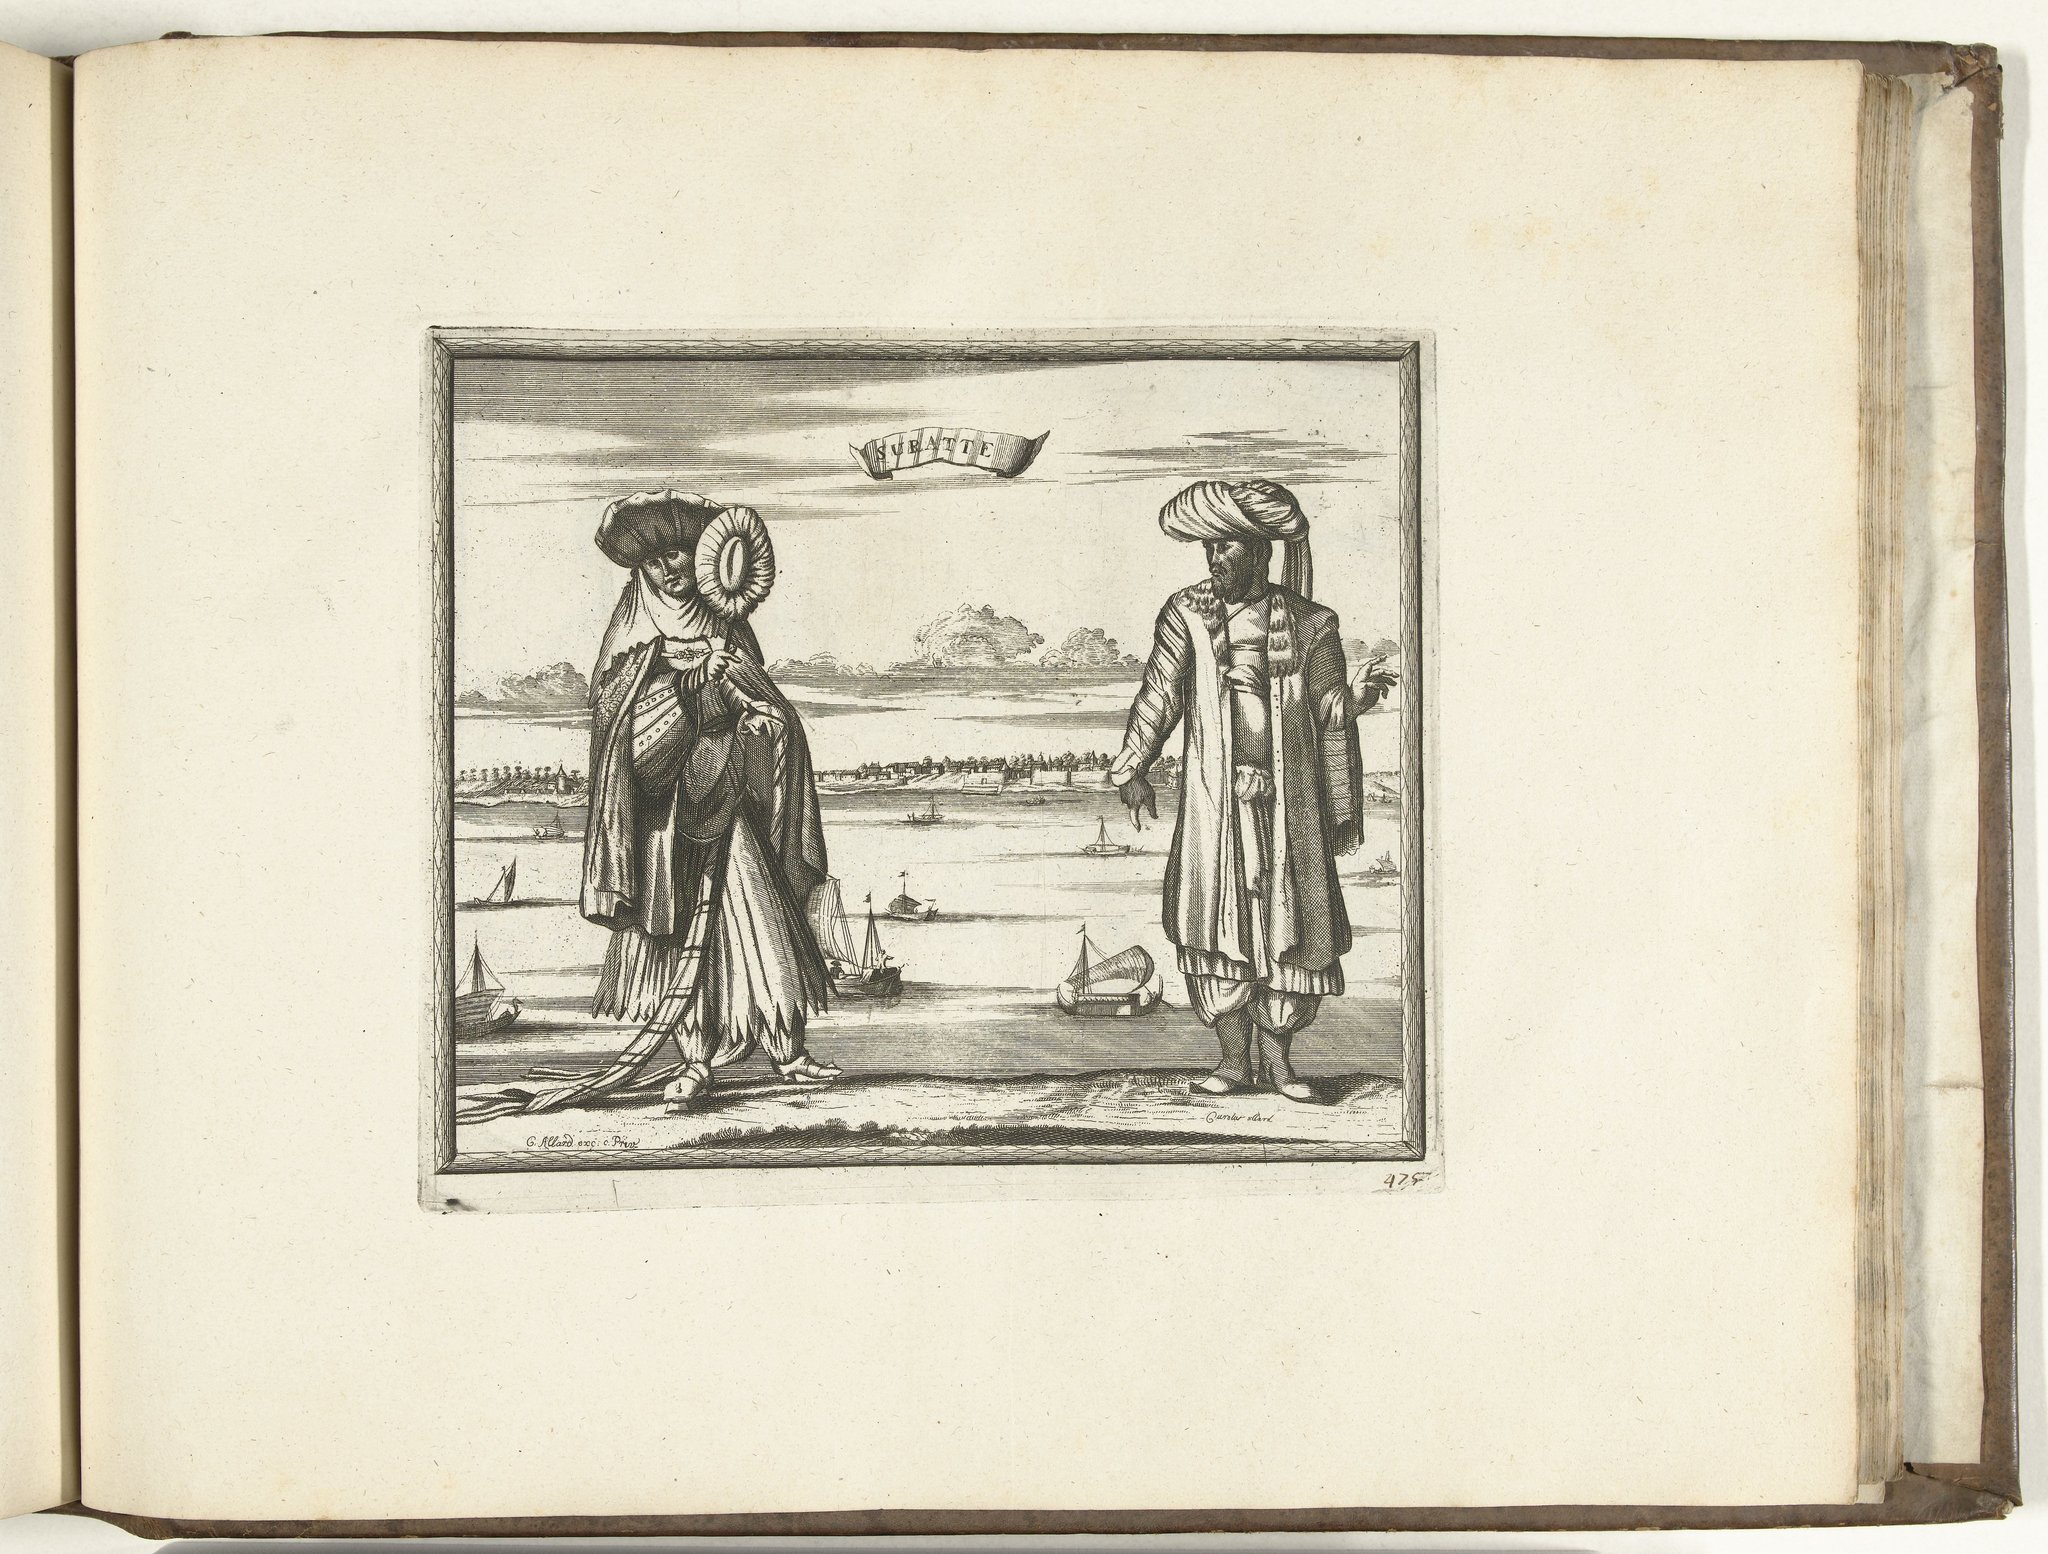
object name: print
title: Inwoners van Suratte, 1726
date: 1726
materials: paper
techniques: etching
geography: amsterdam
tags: folk costume, regional costume, asiatic races and peoples: indians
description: Man en vrouw van Suratte in India, gekleed in lokaal kostuum. Plaat nr. 475 in deel XIX van het prentwerk: Les Forces de l'Europe, Asie, Afrique et Amerique ... Comme aussi les Cartes des Côtes de France et d'Espagne uit 1726, dit tweede deel met 271 met de hand genummerde platen van vermaarde sterke steden en vestingen in het kader van de Spaanse Successieoorlog 1701-1713. Voor het merendeel zijn deze platen gekopieerd naar de anonieme Franse platen van vermaarde sterke steden en vestingen: in Les forces de l'Europe en in: Le theatre de la guerre, dans les Pays-Bas, beide oorspronkelijk uitgegeven door Nicolas de Fer te Parijs (1693-1697) in het kader van de Negenjarige Oorlog.